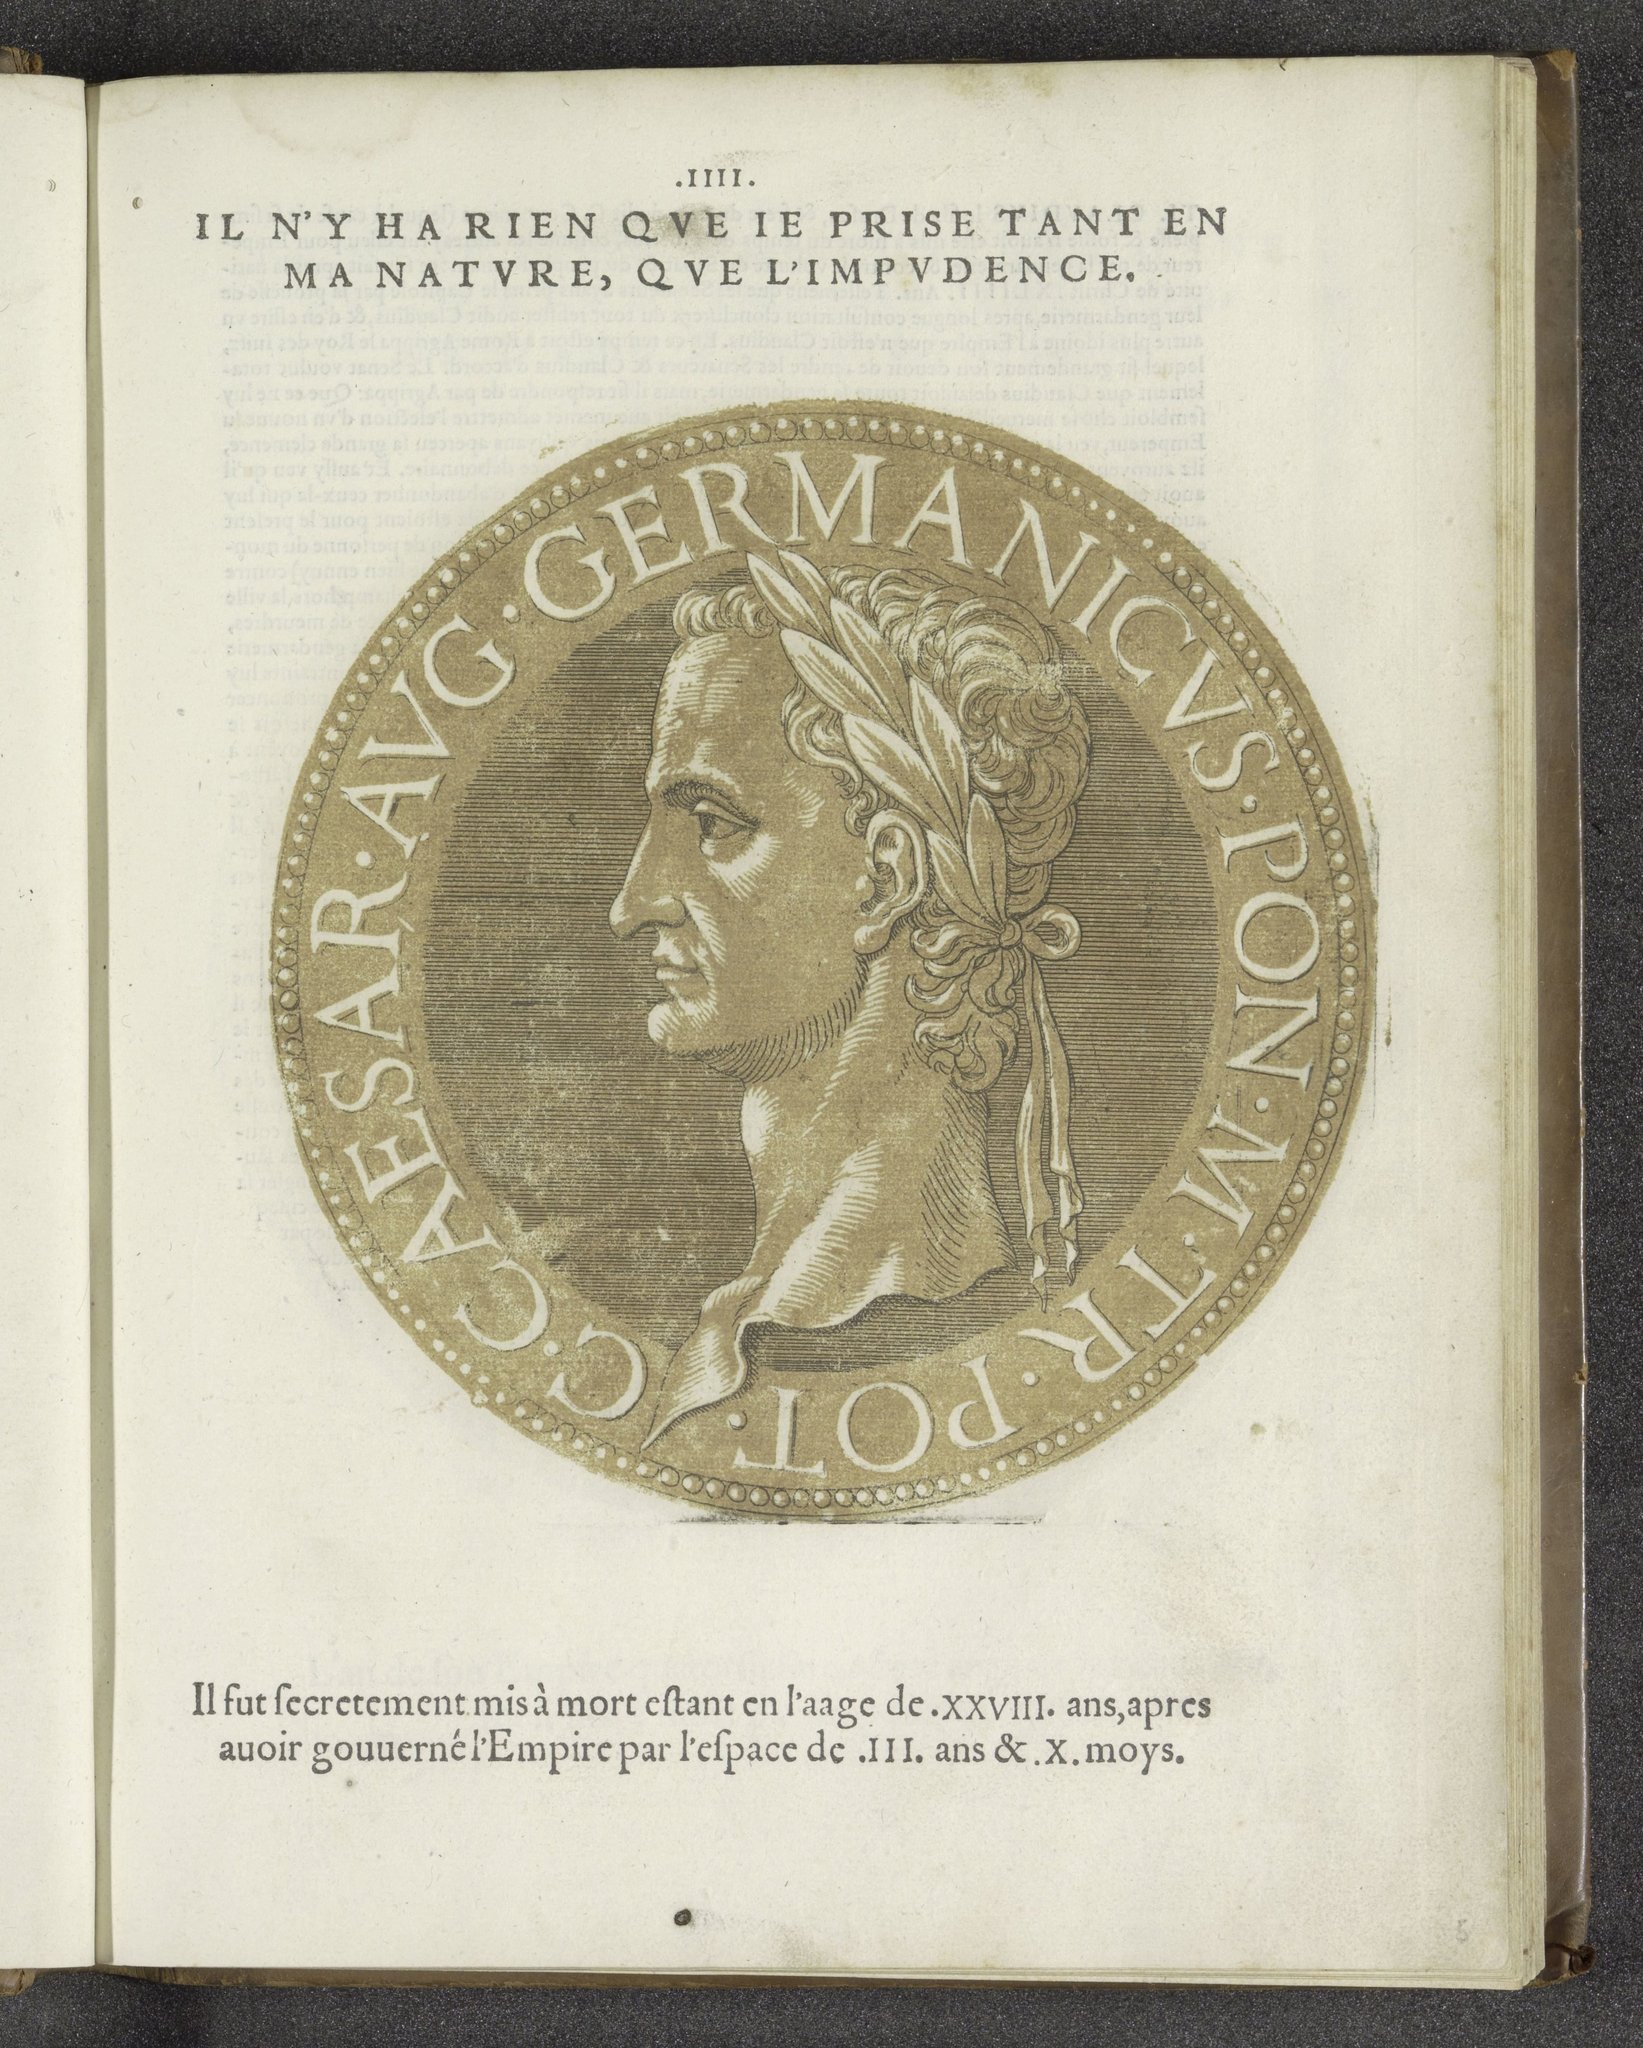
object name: print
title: Portret van keizer Caligula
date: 1557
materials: paper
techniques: woodcut, etching, letterpress printing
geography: antwerp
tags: germany, emperor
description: Portret van Gaius Caesar Augustus Germanicus, bekend als keizer Caligula, op een munt met randschrift. De prent maakt deel uit van een boek over de keizers vanaf Julius Caesar tot en met Karel V en zijn broer Ferdinand.